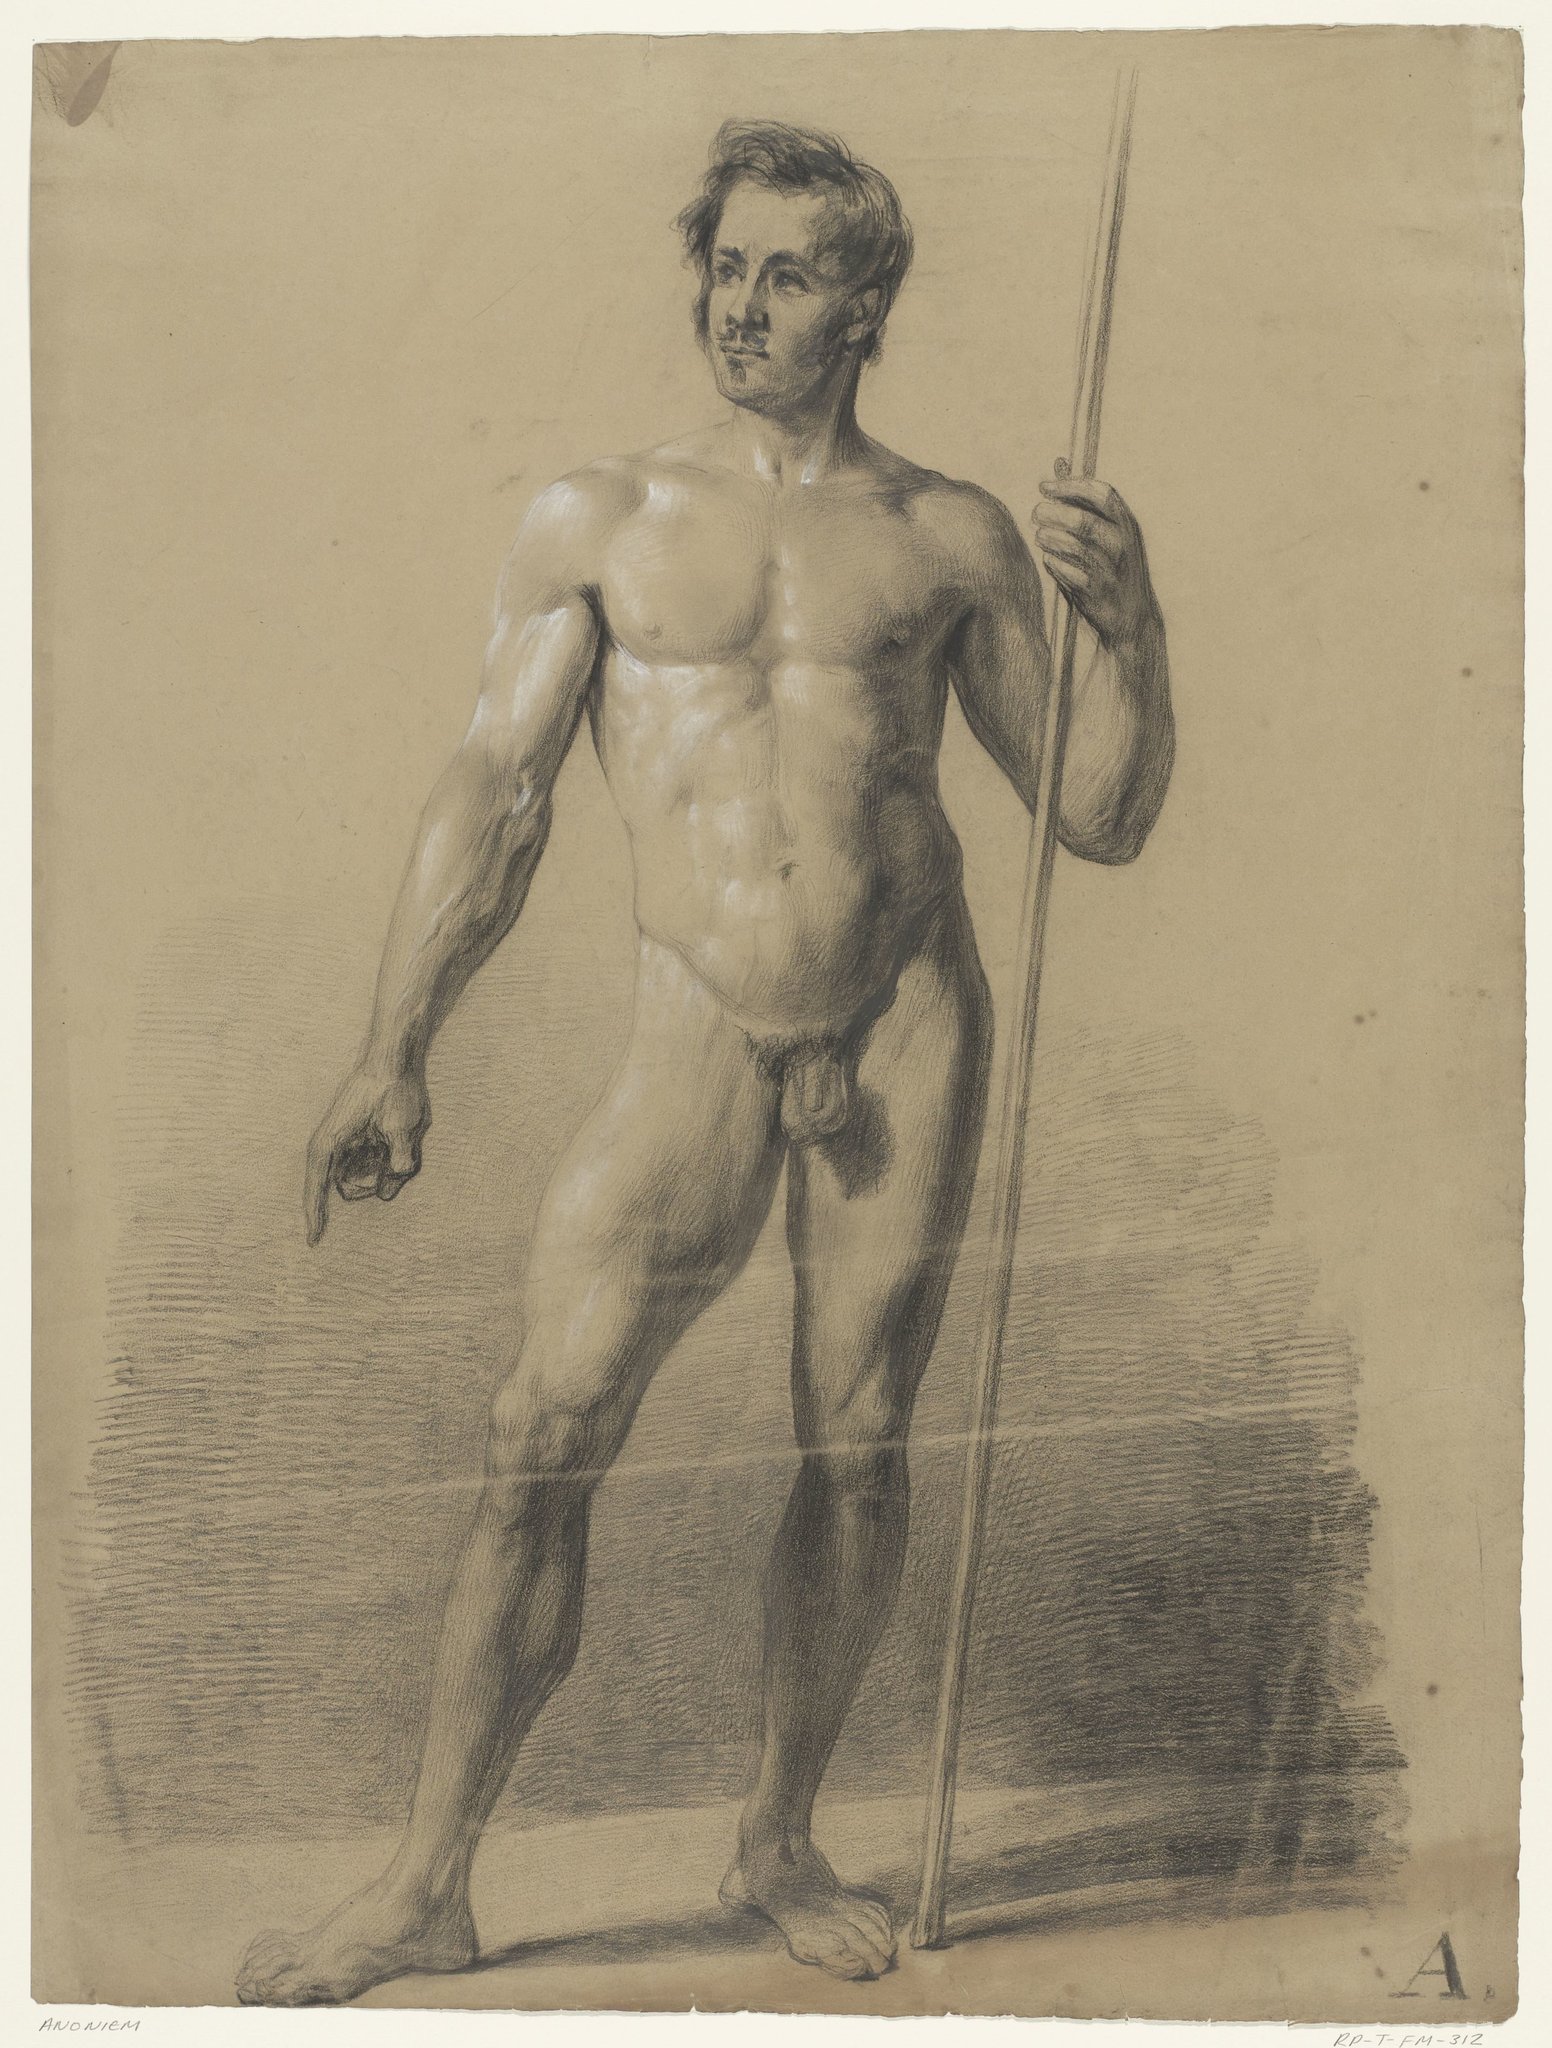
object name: drawing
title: Staand mannelijk naakt met stok, van voren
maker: Anonymous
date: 1842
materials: chalk, paper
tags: standing figure